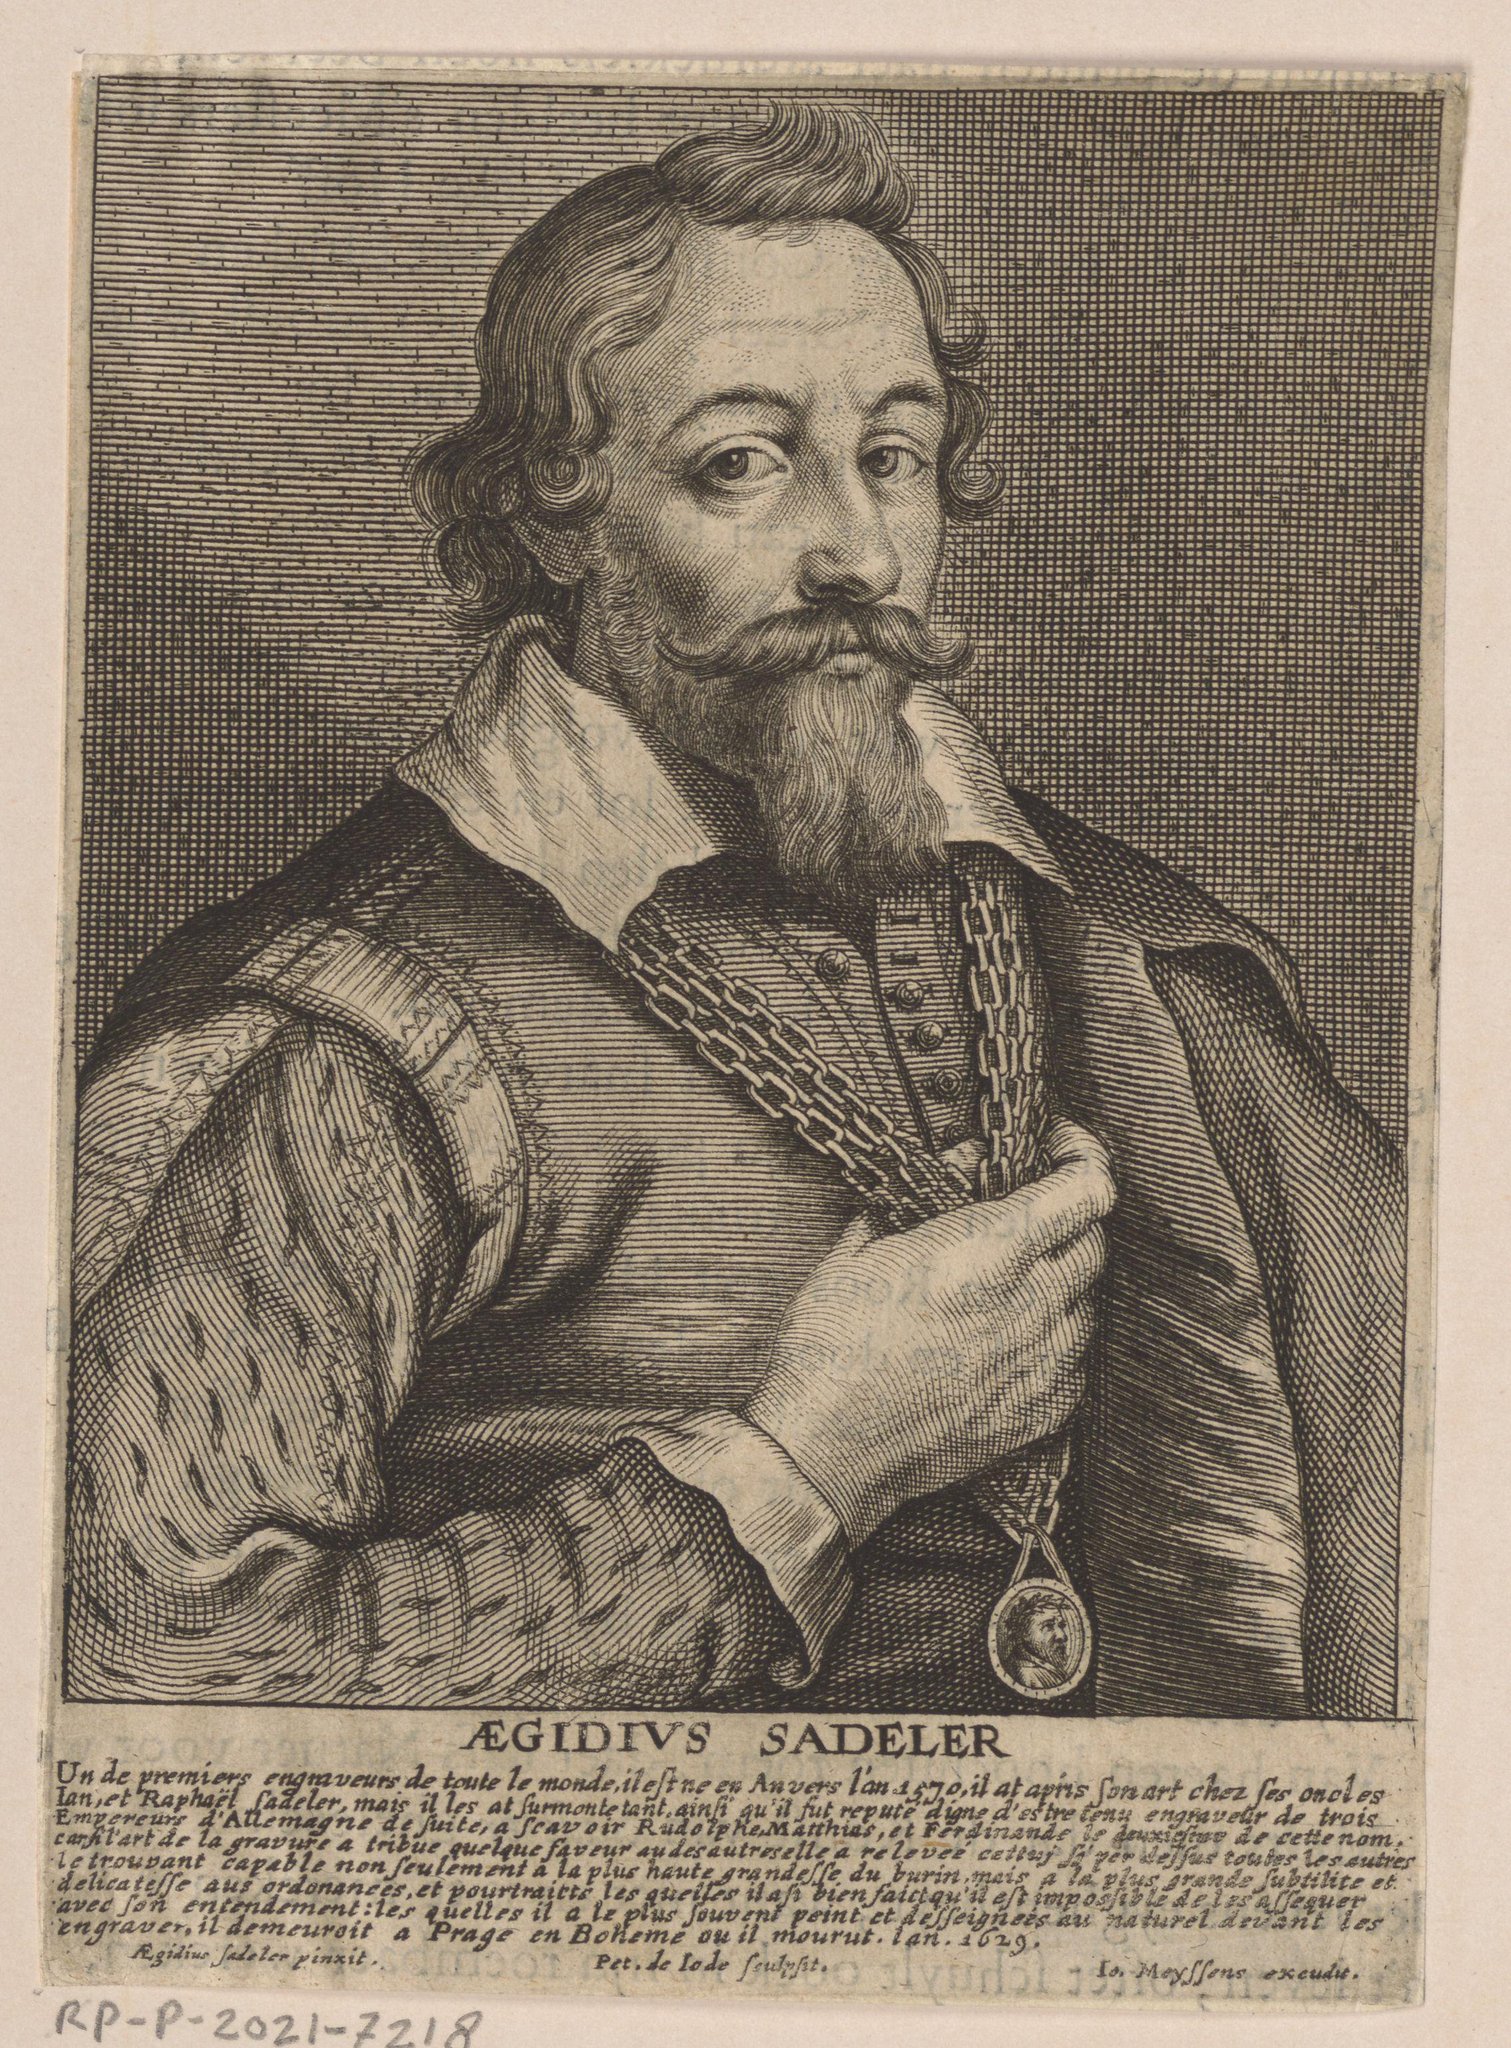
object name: print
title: Portret van Aegidius Sadeler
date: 1662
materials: paper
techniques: engraving, letterpress printing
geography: antwerp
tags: antwerp, prague, aegidius sadeler (ii), historical persons, portrait, self-portrait of graphic artist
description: Prent uit: Bie, Cornelis de. Het gulden cabinet vande edel vry schilder const (...). Antwerpen: Joannes Meyssens, 1662 [1661 foutief op titelpagina]. Prent zonder tekst op verso gebruikt in: Image de divers hommes d'esprit sublime, qui par leur art et science devraient vivre éternellement et desquels la louange et renommée faict estonner le monde. Antwerpen: Joannes Meyssens, 1649.